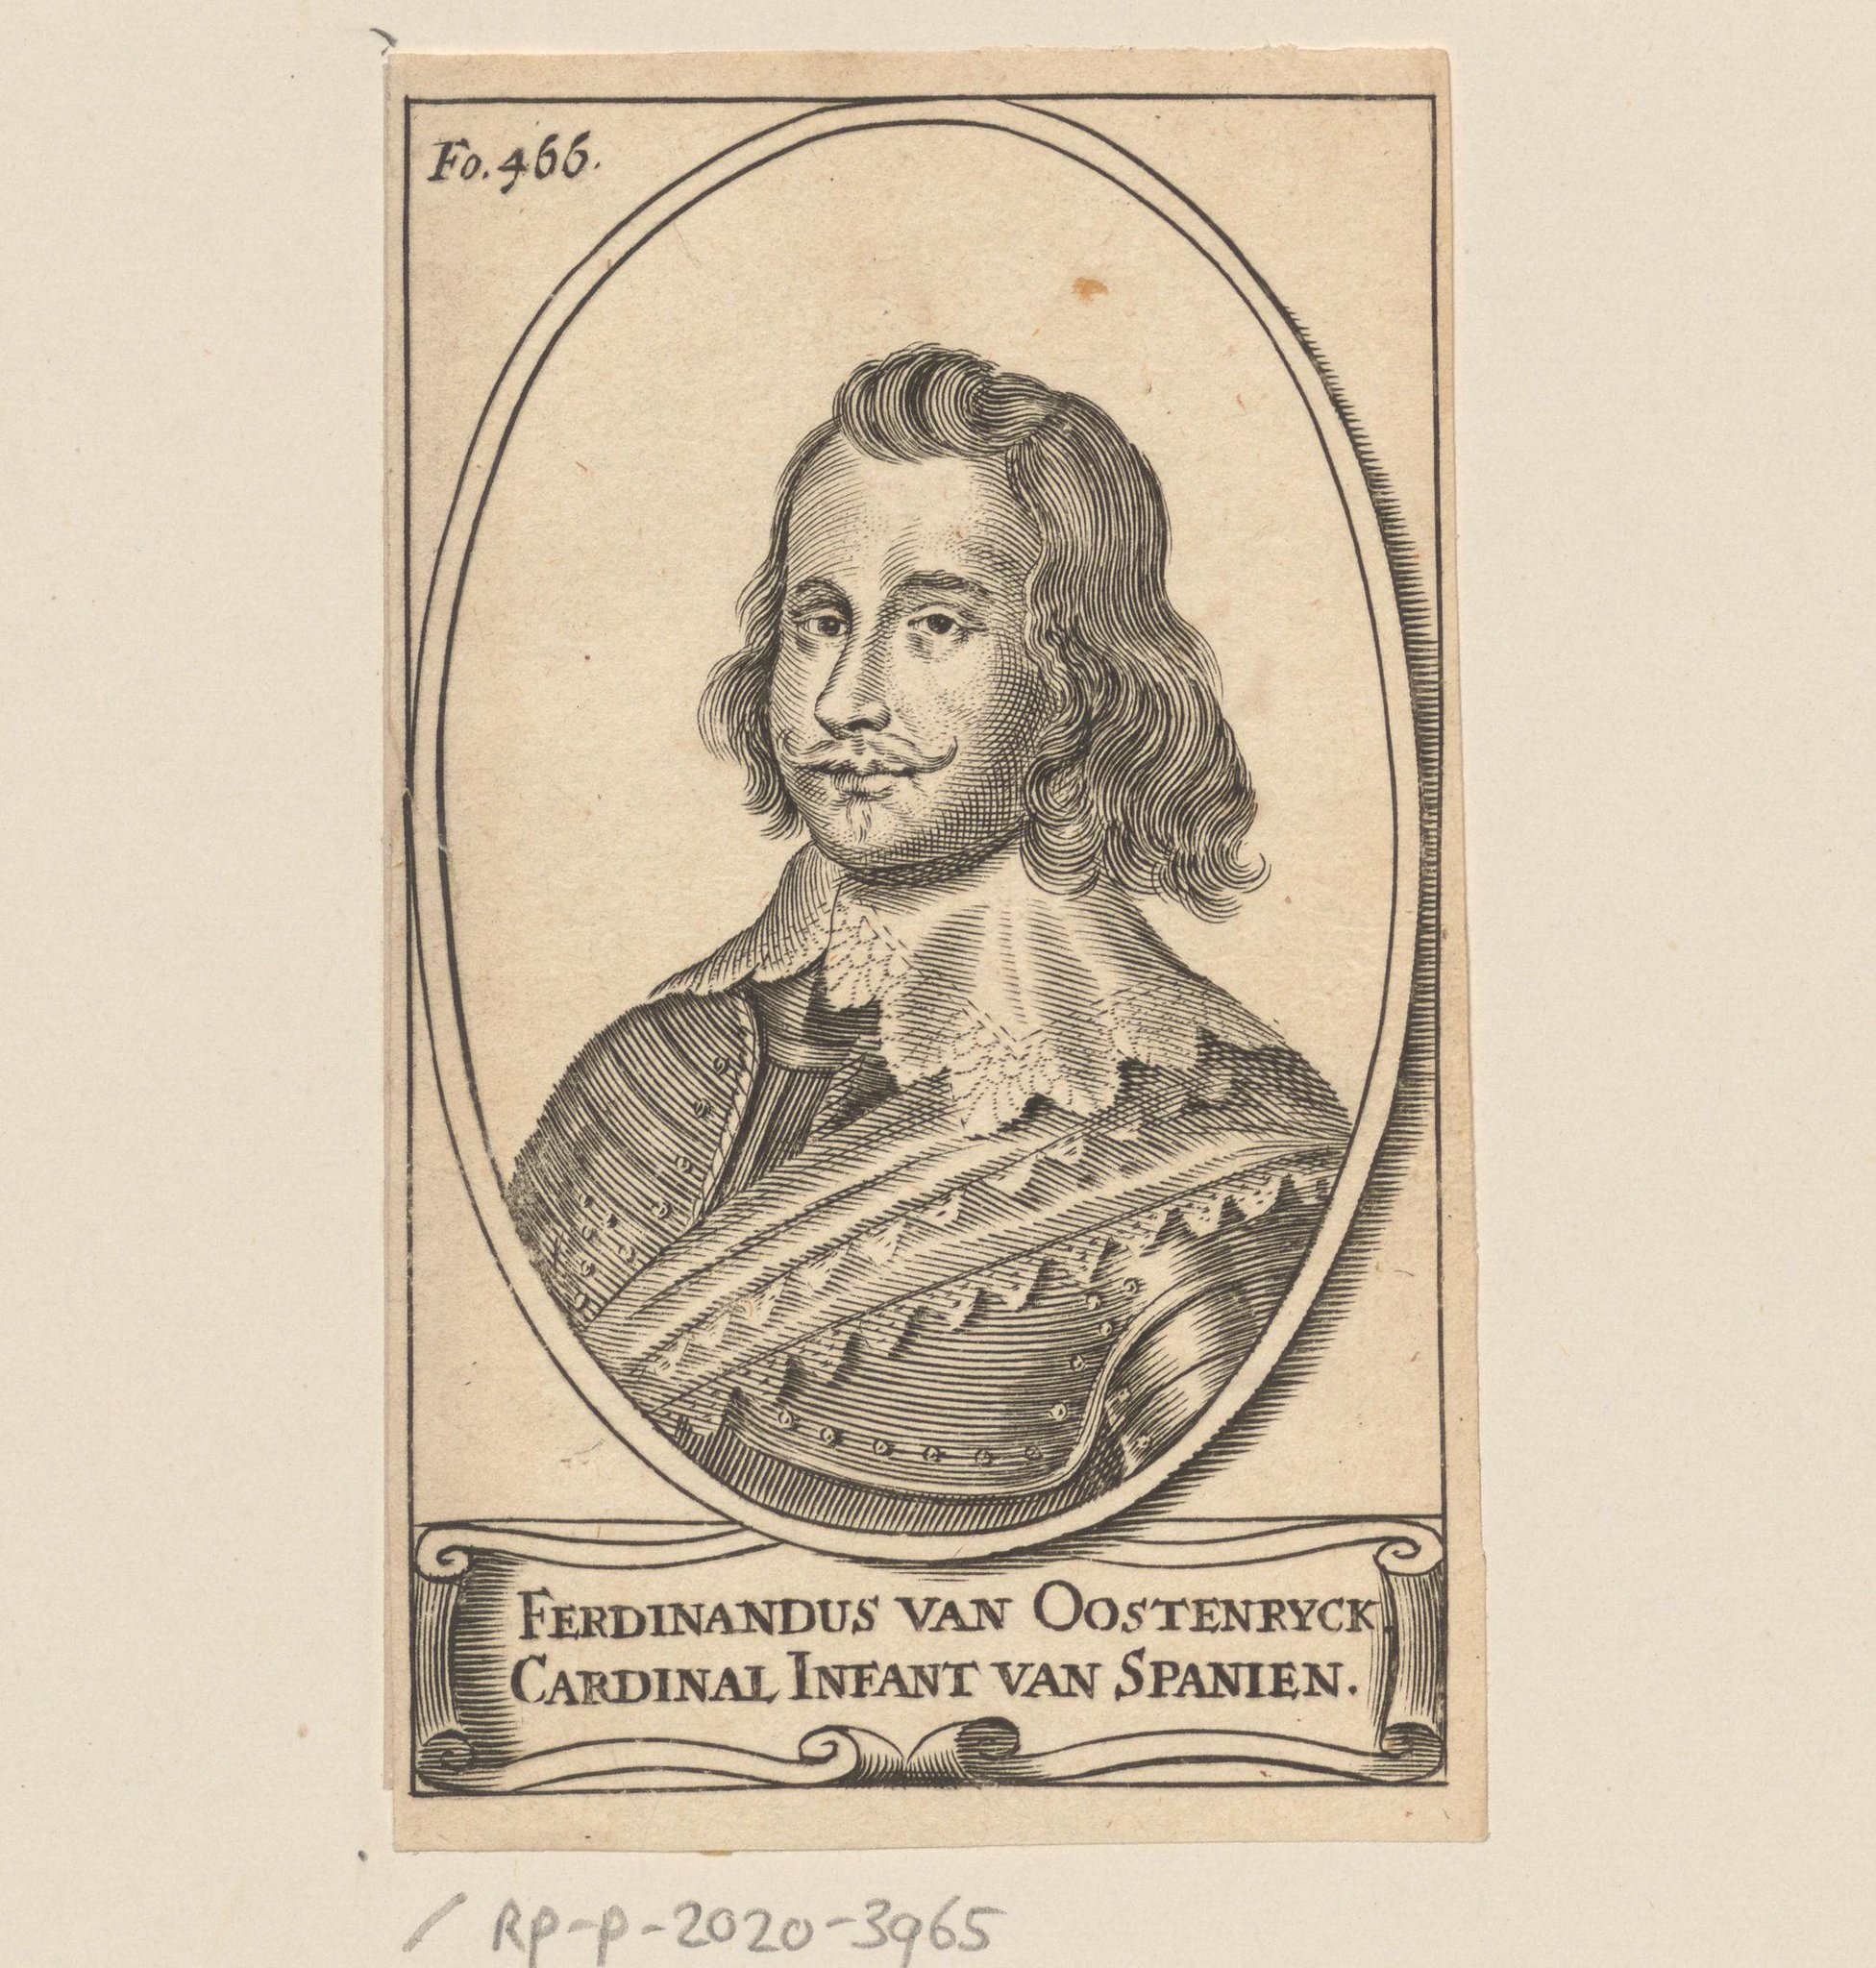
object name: print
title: Portret van Ferdinand van Oostenrijk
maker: Anonymous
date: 1640-1700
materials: paper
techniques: engraving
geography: northern netherlands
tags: brussels, landvoogd der zuidelijke nederlanden ferdinand van oostenrijk, historical persons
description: Met onderschrift in het Nederlands. Linksboven: Fo. 466.